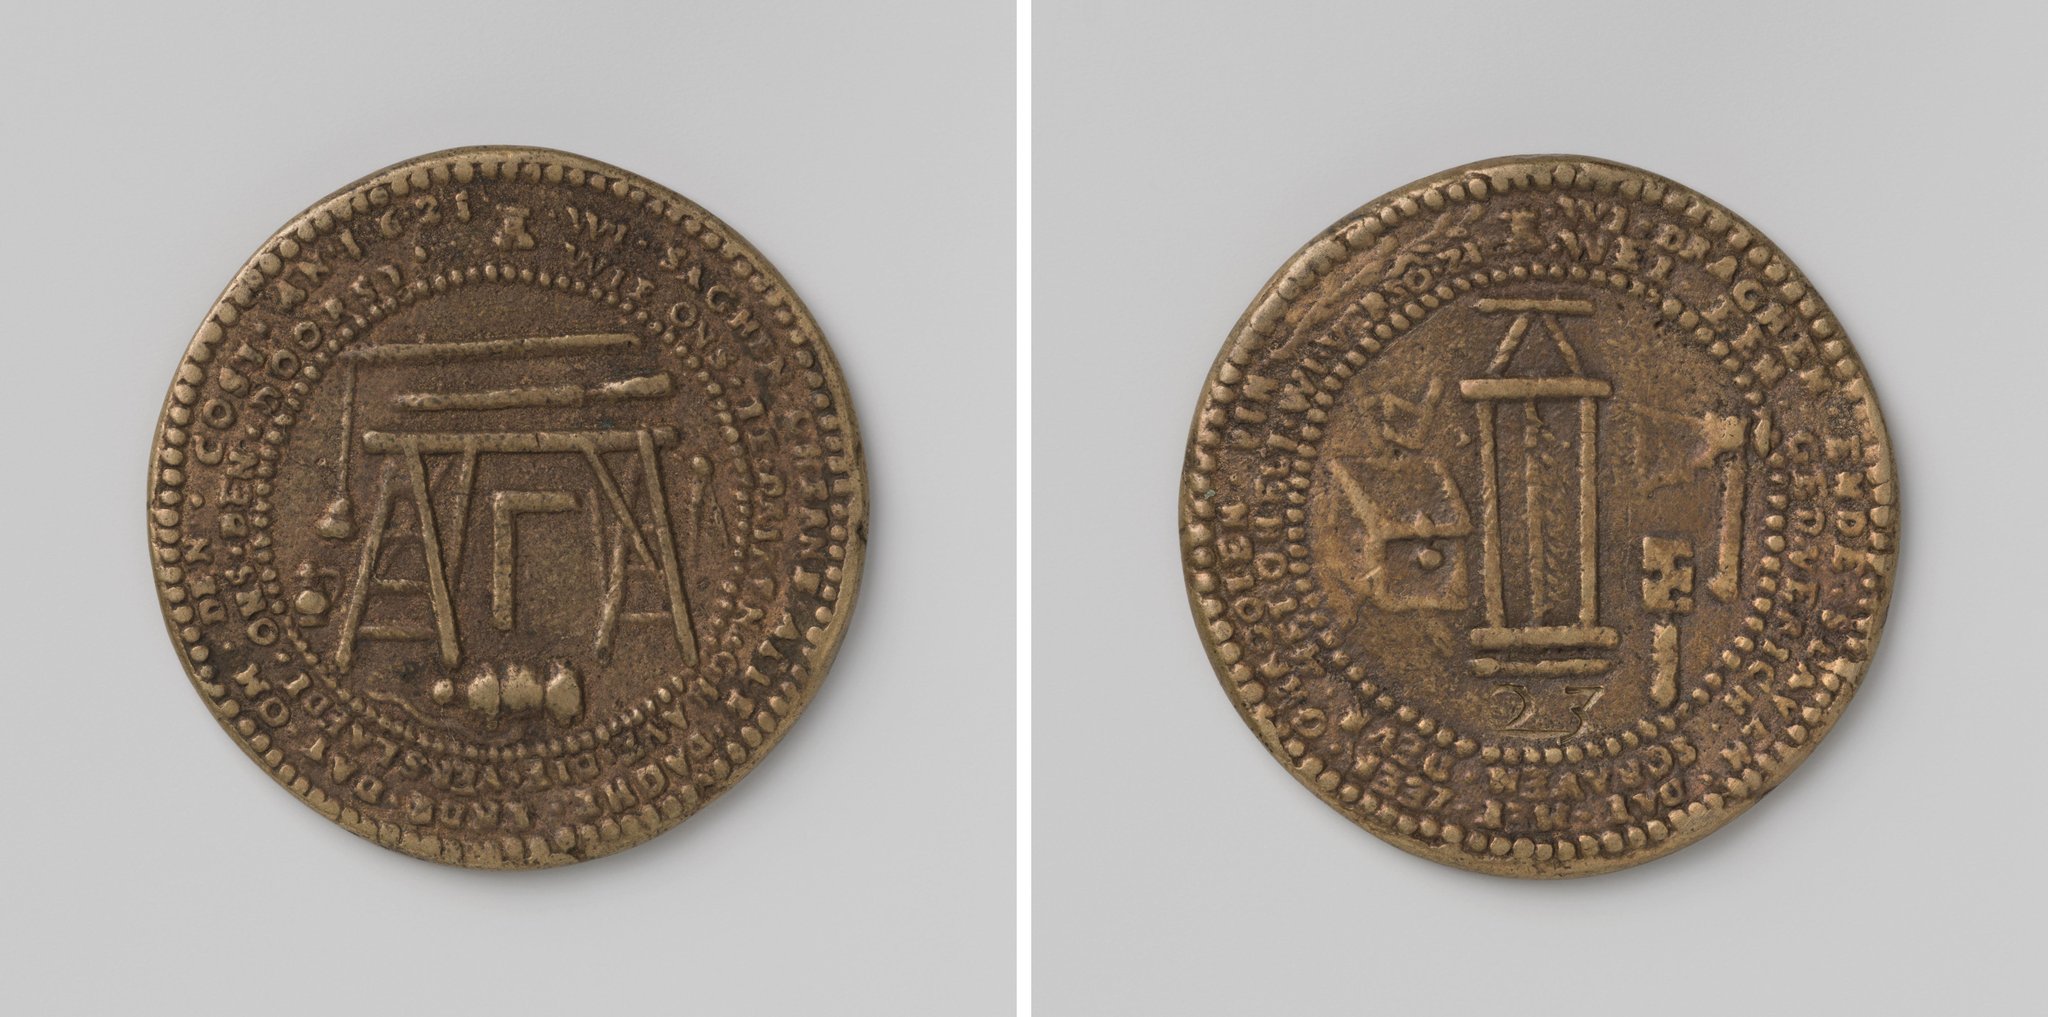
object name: medal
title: Houtzagersgilde van Middelburg, gildepenning met no. 23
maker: Anonymous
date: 1621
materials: brass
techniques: casting, engraving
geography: middelburg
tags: middelburg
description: Messing penning. Voorzijde: schraag, waterpas, boor, winkelhaak, paslood en passer; daaronder: liggende bierkan binnen tweeregelig omschrift. Keerzijde: houtzaag, kist, bijl, houtzagerskruk of sleutel en andere werktuigen boven cijfer 23 binnen tweeregelig omschrift